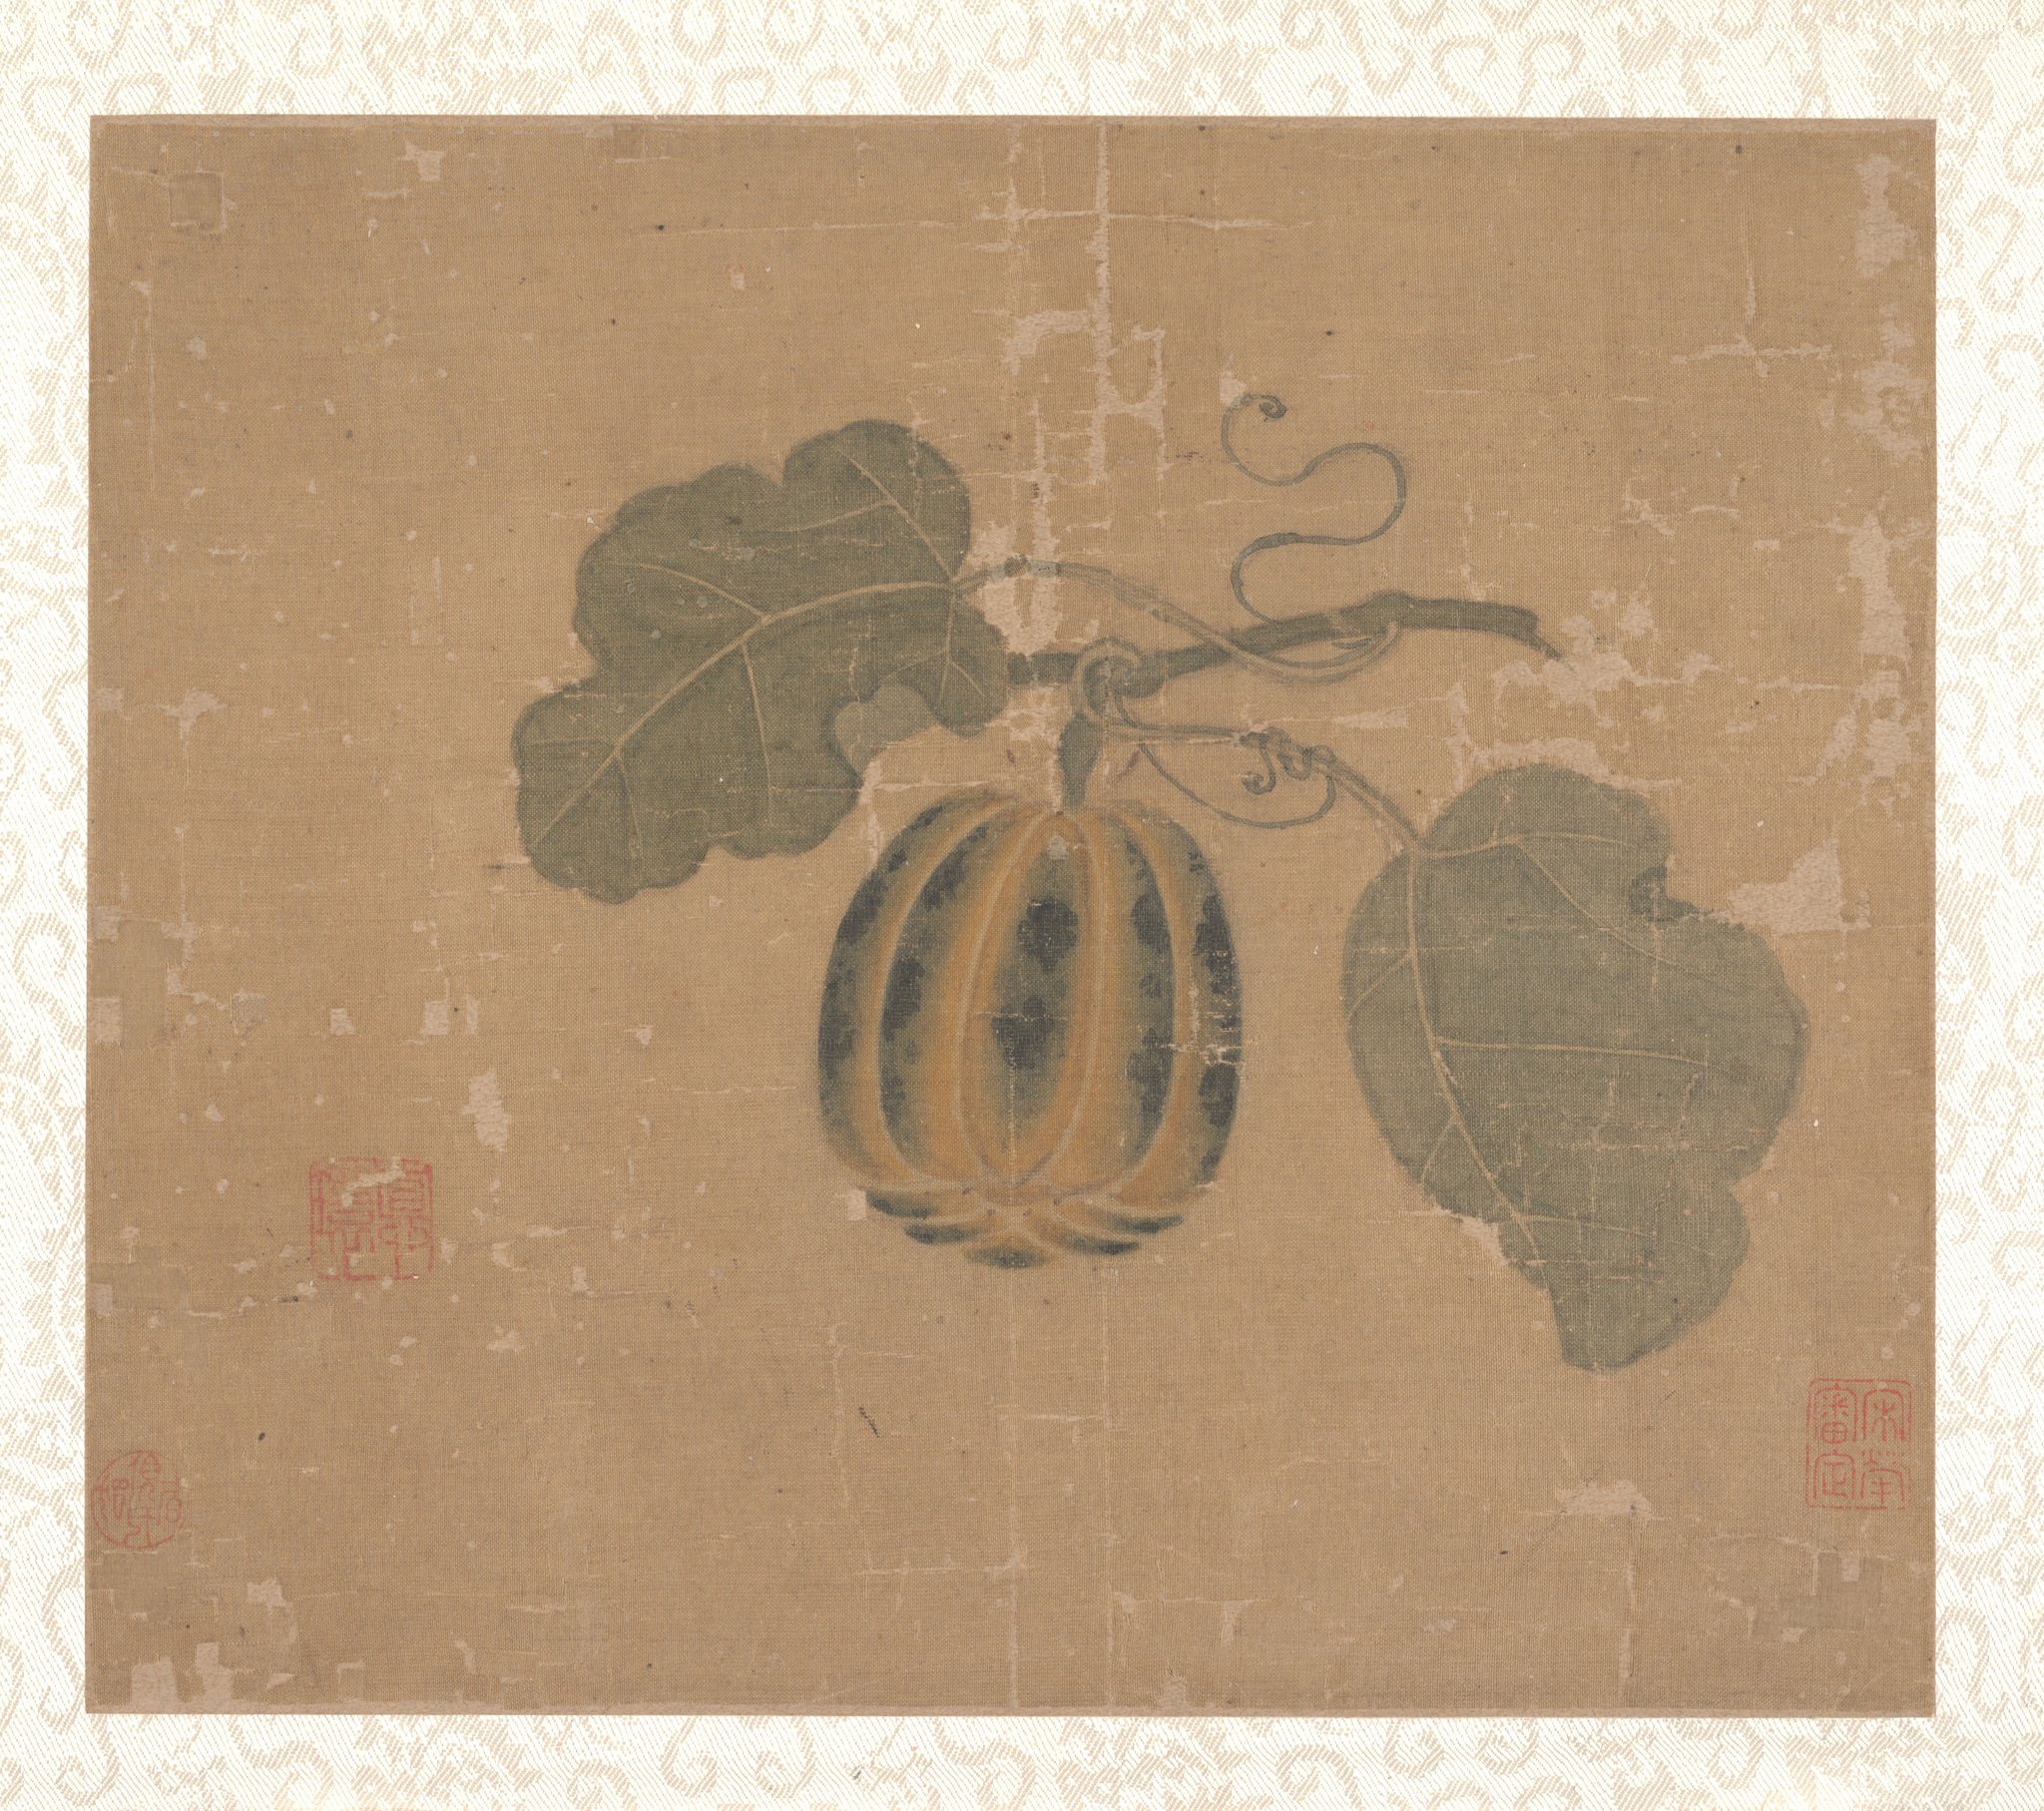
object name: album leaf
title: Squash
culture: chinese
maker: unidentified artist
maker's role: artist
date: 960-1279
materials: ink, silk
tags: fruit